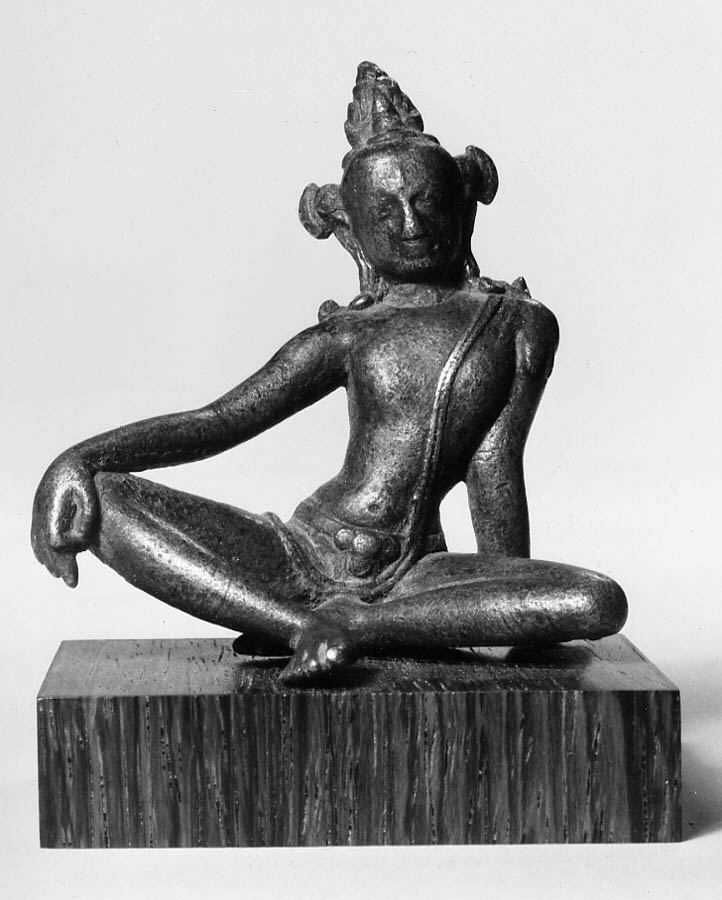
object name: figurine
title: Seated Maitreya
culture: indian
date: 801-900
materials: bronze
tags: buddhism,maitreya